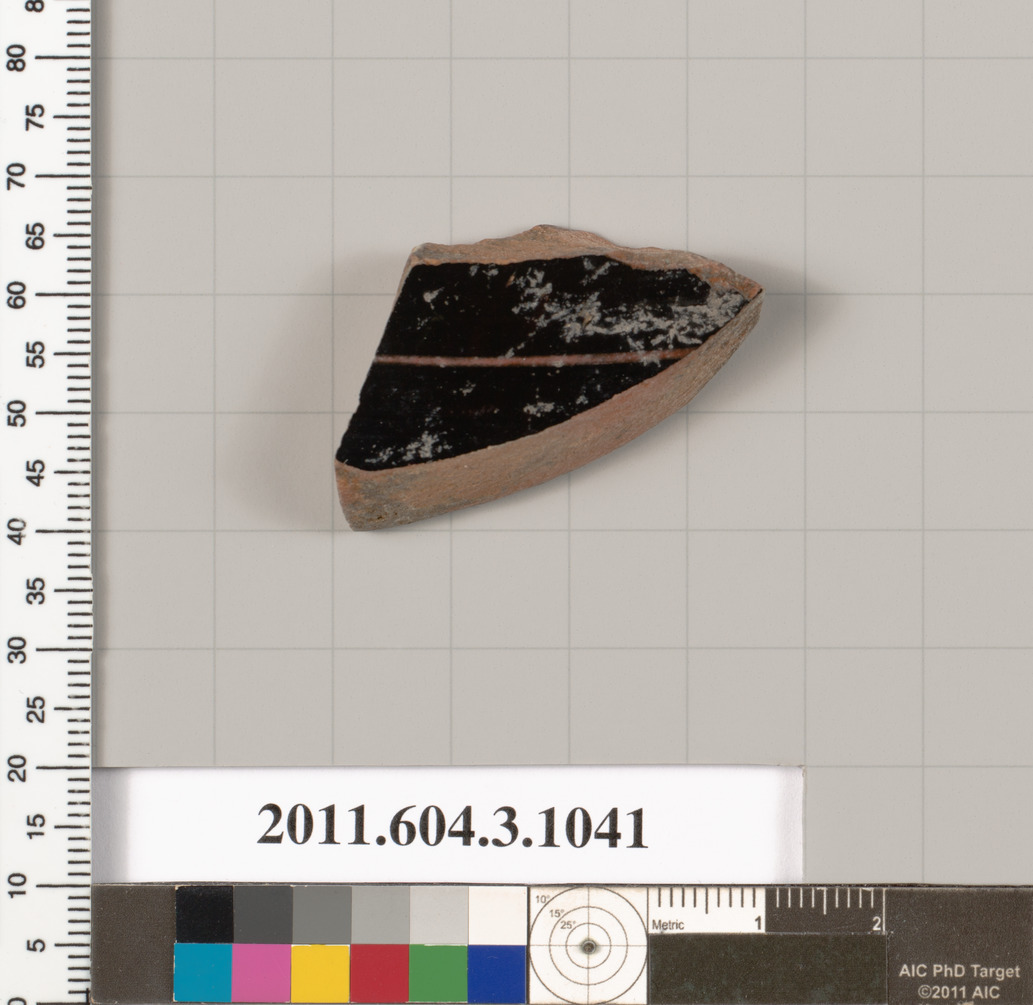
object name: plate fragment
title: Terracotta fragment of a plate?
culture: greek, attic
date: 534-501 BCE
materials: terracotta